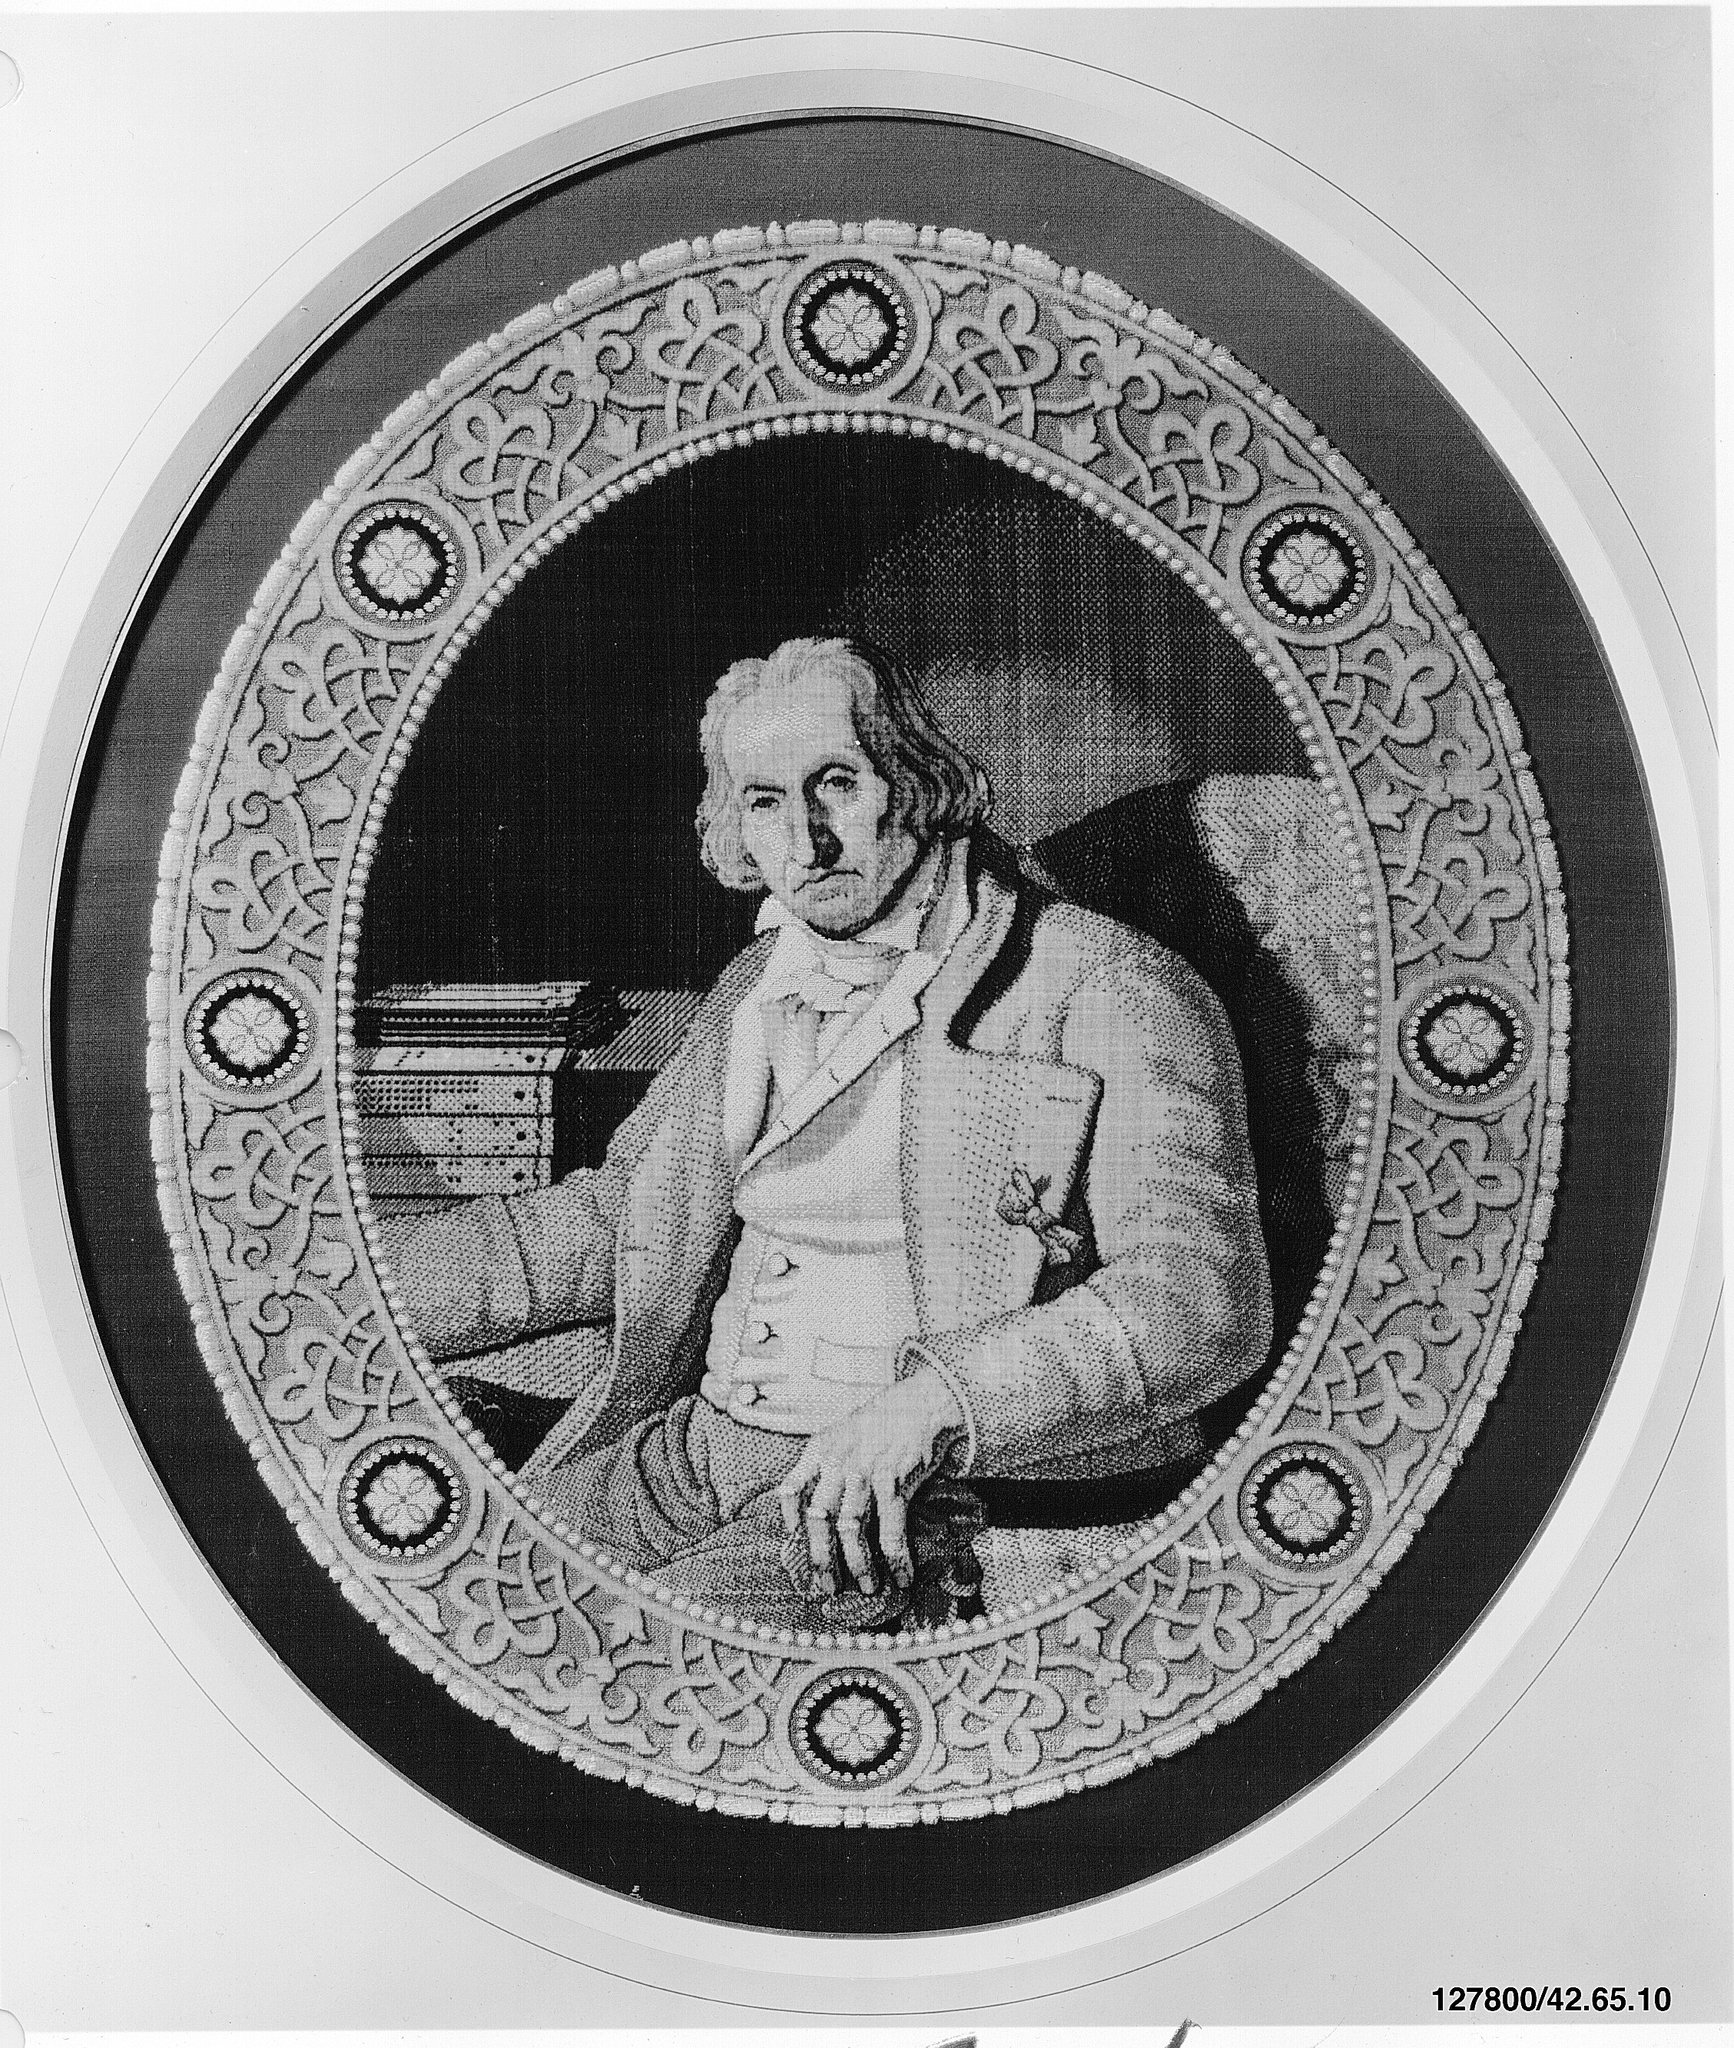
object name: portrait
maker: a. bois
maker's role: maker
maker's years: 1800-1900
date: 1855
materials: silk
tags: men,portraits